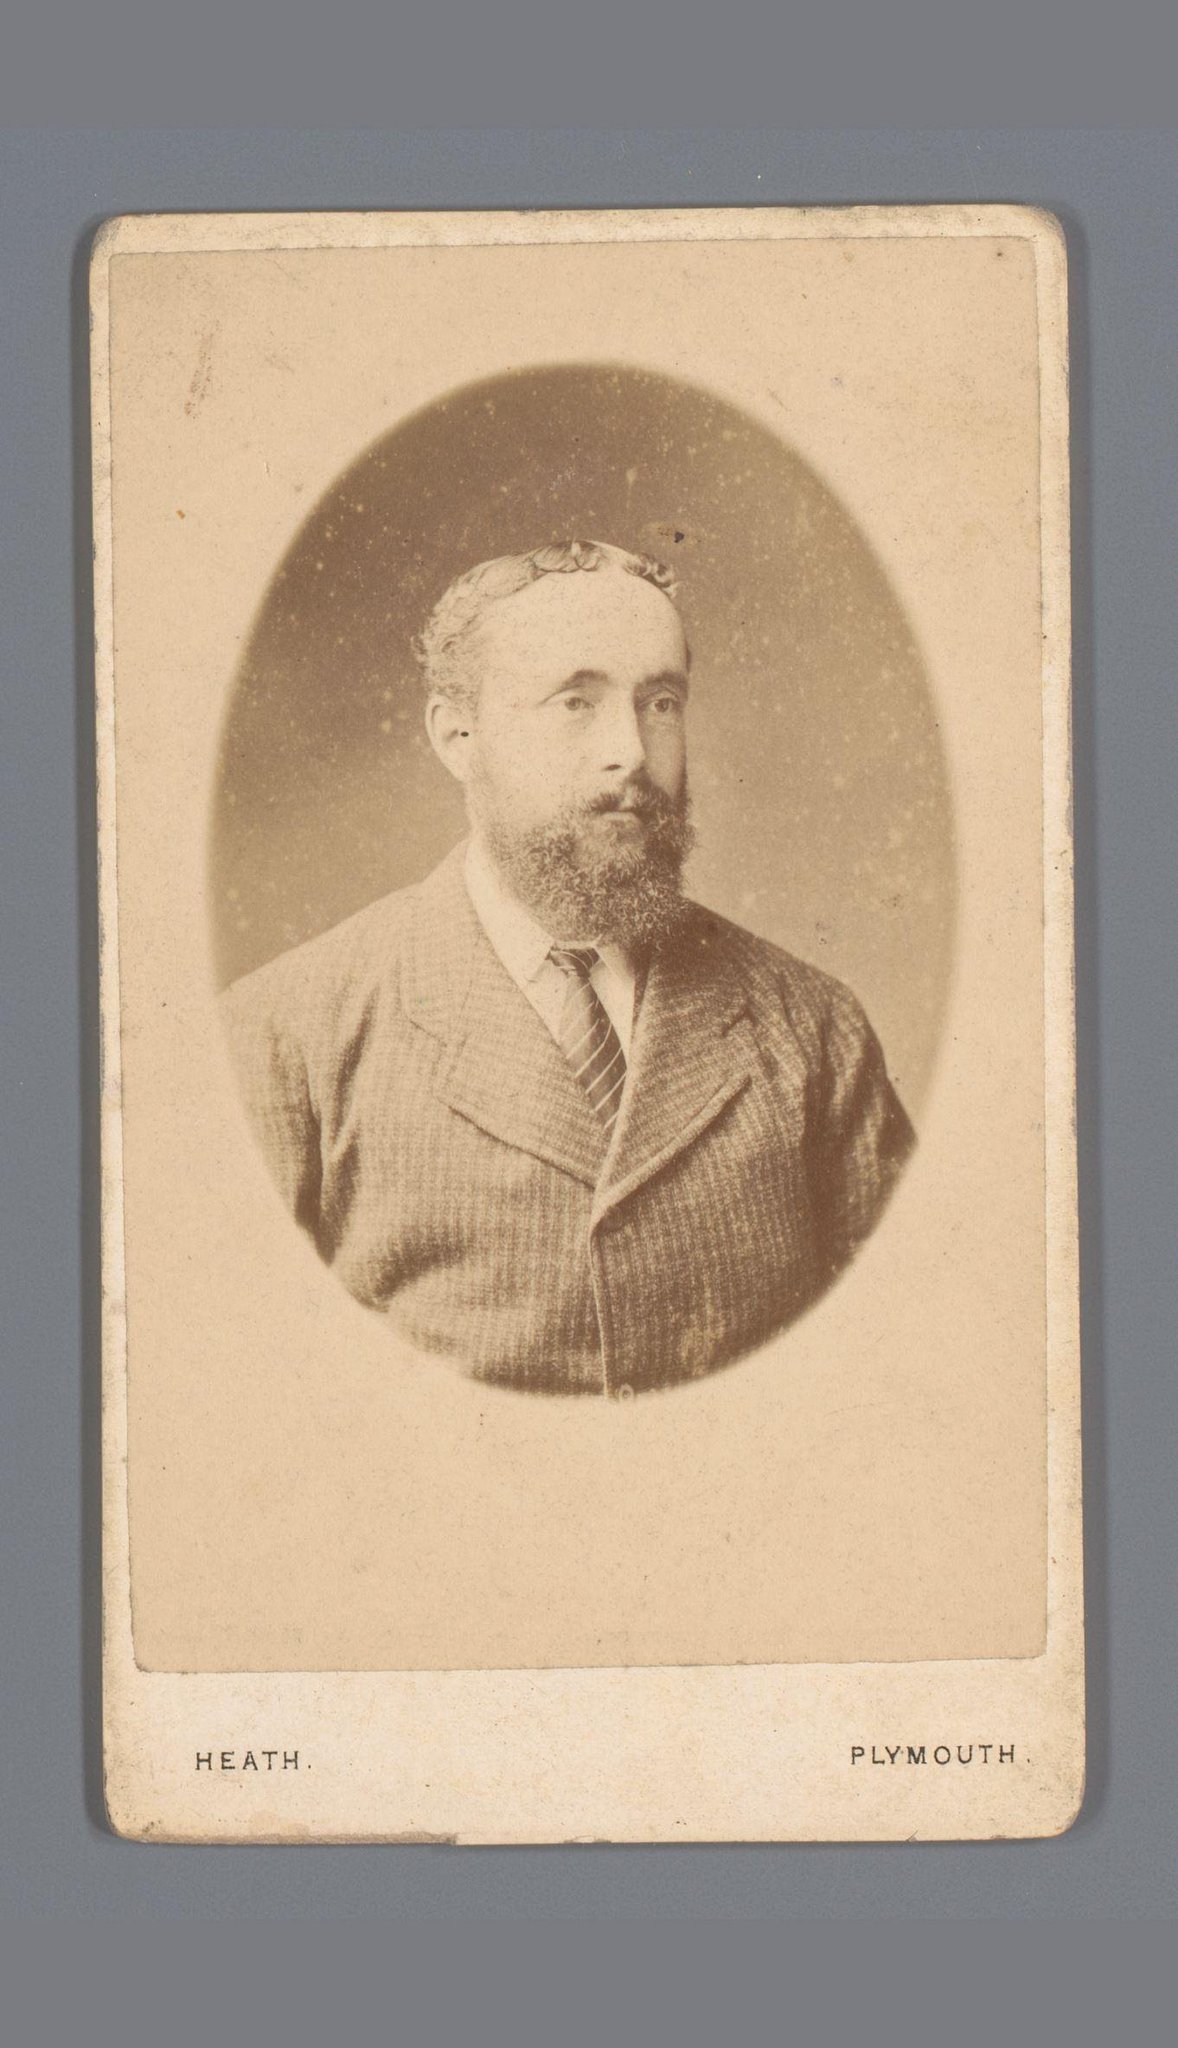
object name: photograph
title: Portret van een onbekende man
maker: joseph gould bullingham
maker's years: 1849-1910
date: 1879-1889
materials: cardboard, paper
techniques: albumen print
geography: plymouth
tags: adult man, anonymous historical person portrayed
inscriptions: number: ‘No 23569’, inscription: ‘OPTICIAN to the ROYAL EYE INFIRMARY/ MAKER OF NAUTICAL & MATHEMATICAL INSTRUMENTS./ OPERA GLASSES, TELESCOPES, &c./ SPECTACLES CORRECTLY ADAPTED TO THE SIGHT./ Please quote this Number when ordering copies.’